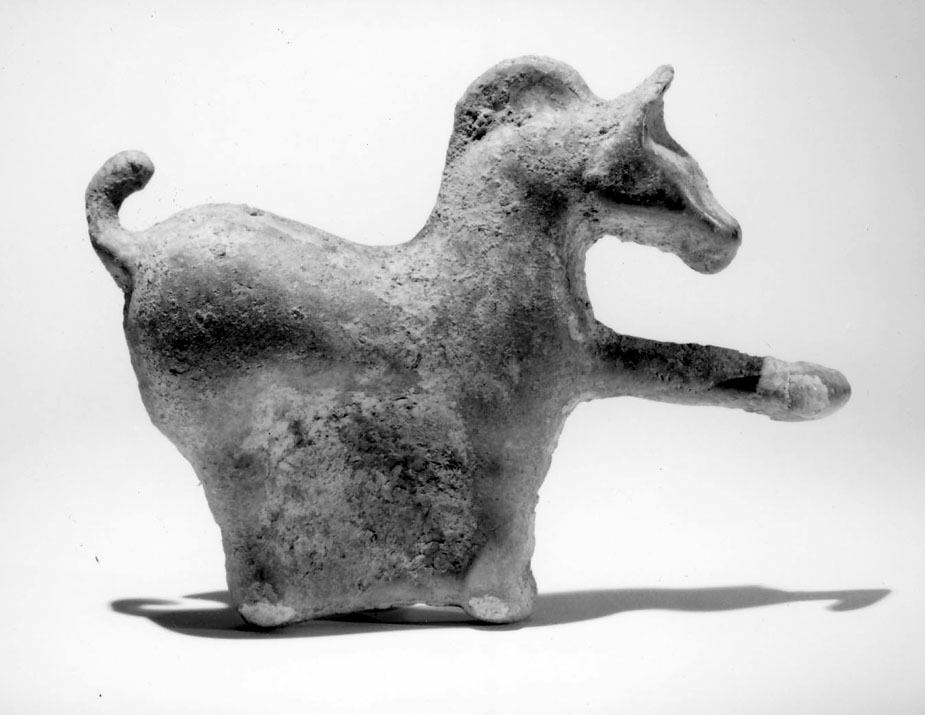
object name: belt buckle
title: Belt Buckle in Shape of Horse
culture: japanese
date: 200-538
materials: bronze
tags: horses